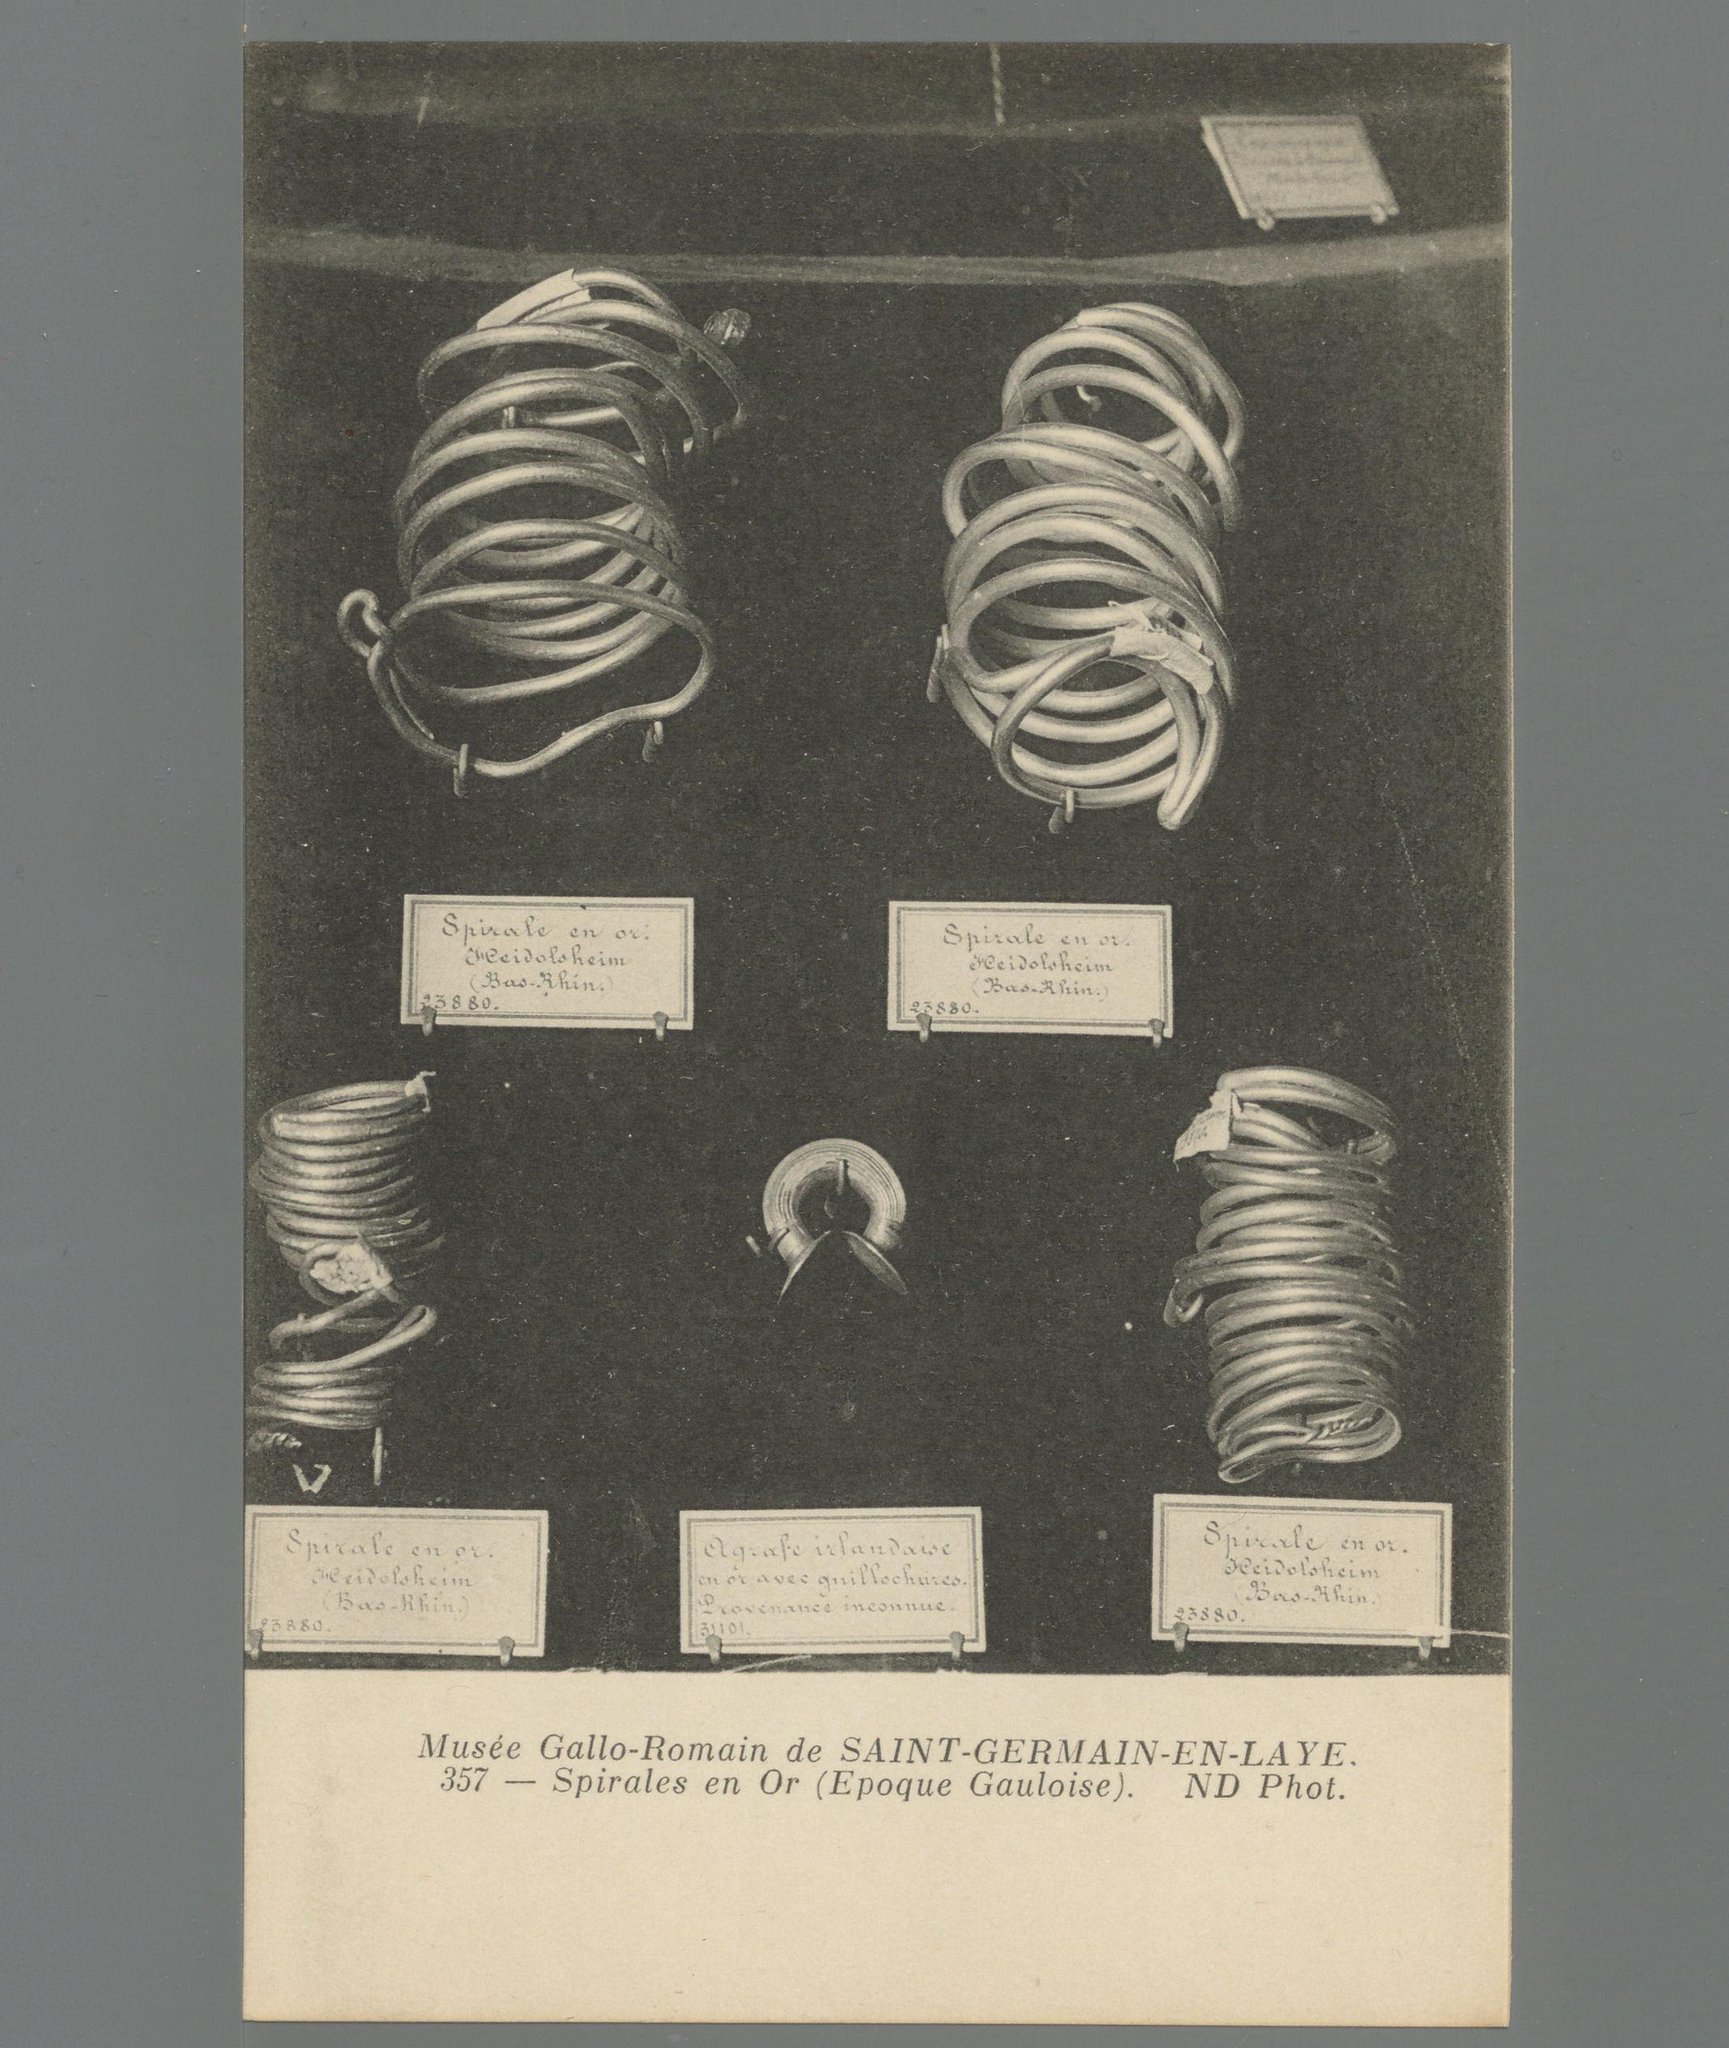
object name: photomechanical print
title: Musée Gallo-Romain de Saint-Germain-en-Laye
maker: Anonymous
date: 1903-1918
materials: cardboard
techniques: photograph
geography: paris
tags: ornaments, jewels, permanent exhibition, museum, minerals and metals: gold